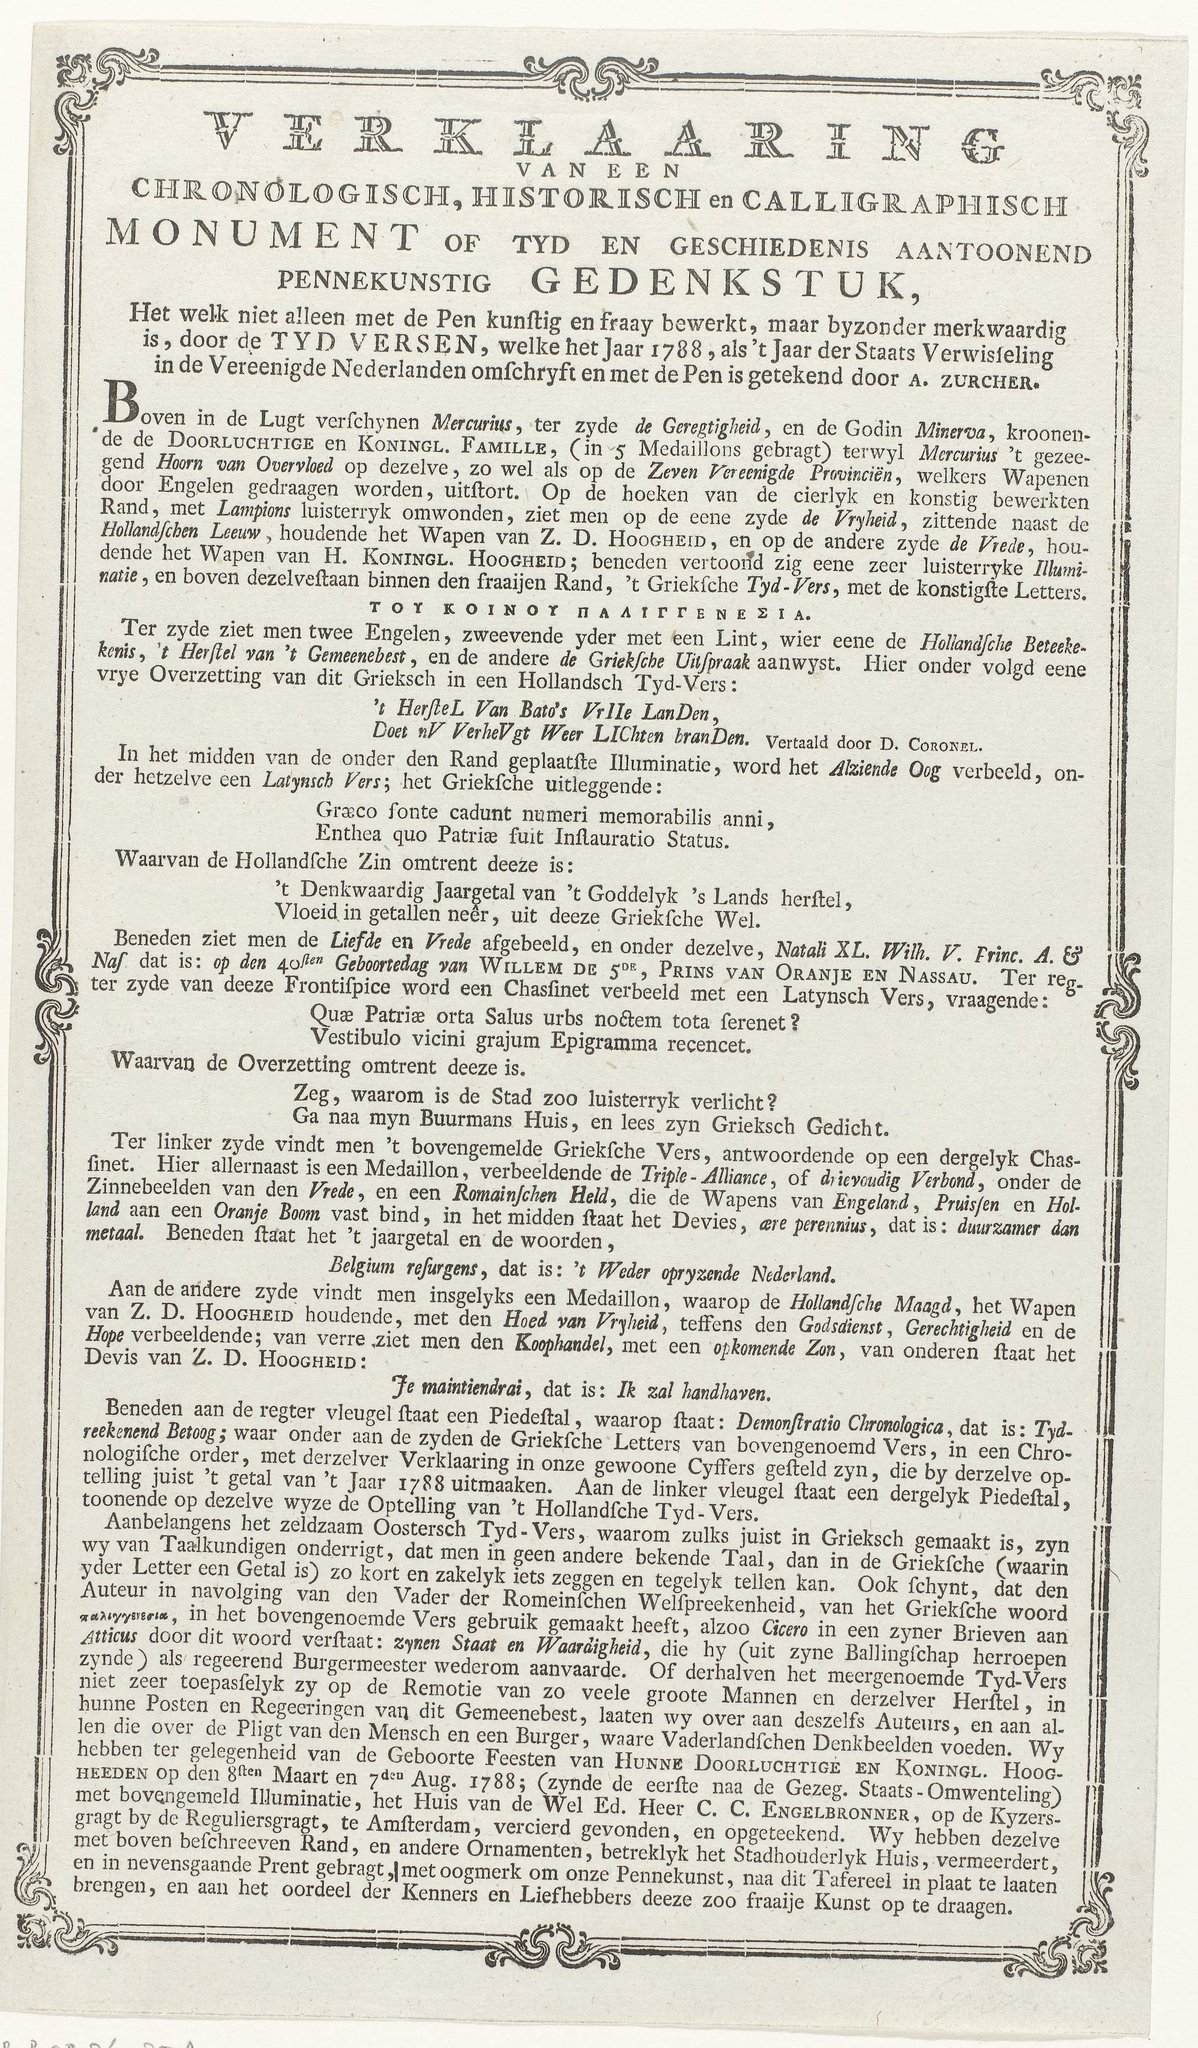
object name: text sheet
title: Verklaring bij de allegorie met kalligrafie en de illuminatie van het huis van C.C. Engelbronner te Amsterdam, 1788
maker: Anonymous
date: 1788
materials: paper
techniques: letterpress printing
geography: amsterdam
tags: william v (prince of orange), cleves, amsterdam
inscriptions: collector's mark: Lugt 2228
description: Tekstblad met de verklaring van de allegorische prent en kalligrafie (en tijdvers) in het Grieks en Nederlands bij de 40ste verjaardag van prins Willem V op 8 maart 1788. Met een beschrijving en uitleg van de voorstelling en de illuminatie van het huis van C.C. Engelbronner te Amsterdam.